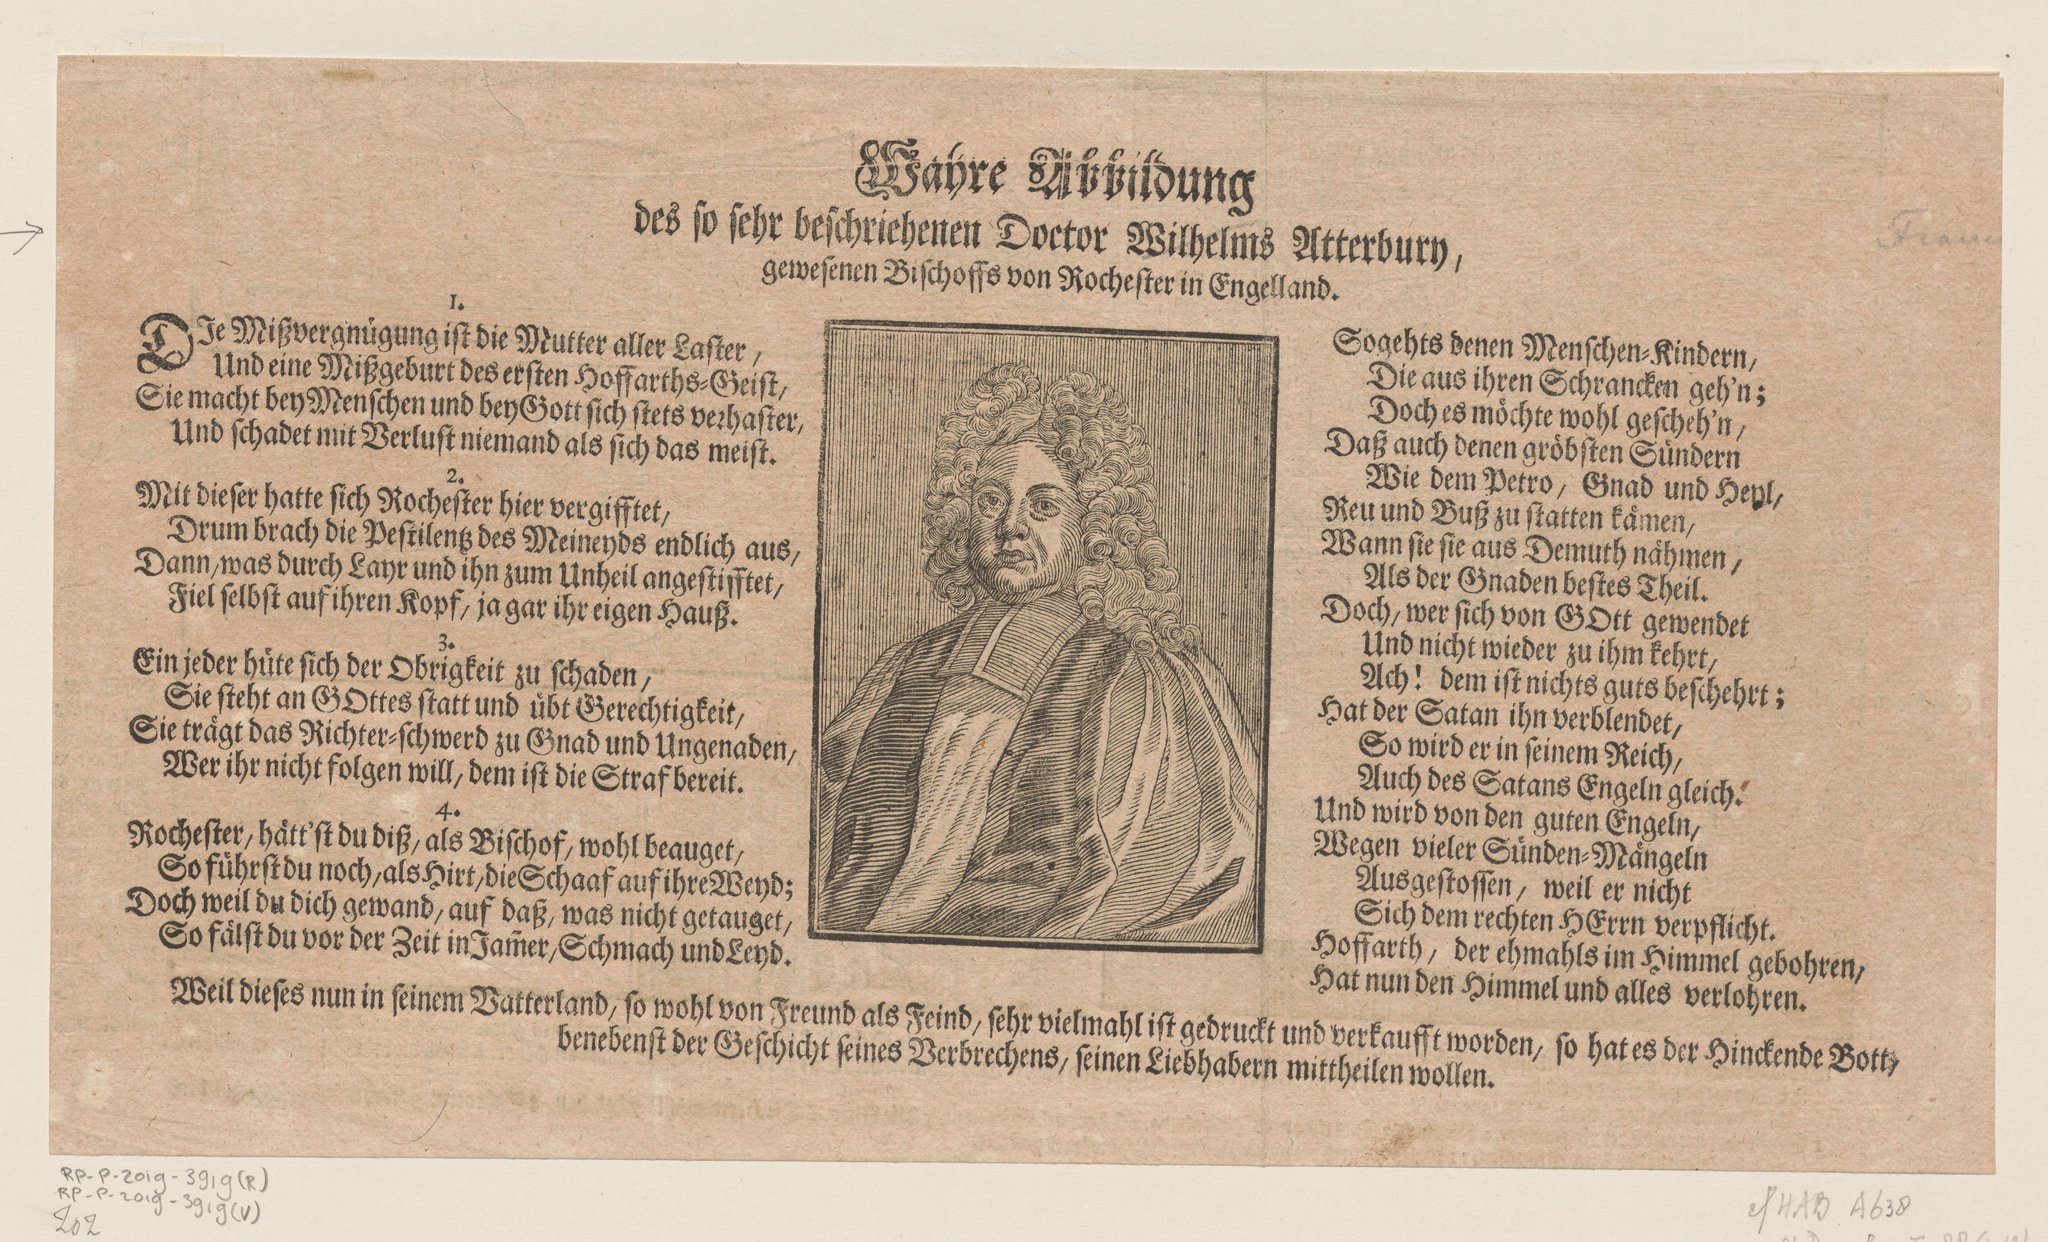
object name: print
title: Portret van Francis Atterbury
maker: Anonymous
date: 1723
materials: paper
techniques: letterpress printing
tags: politician, historical persons